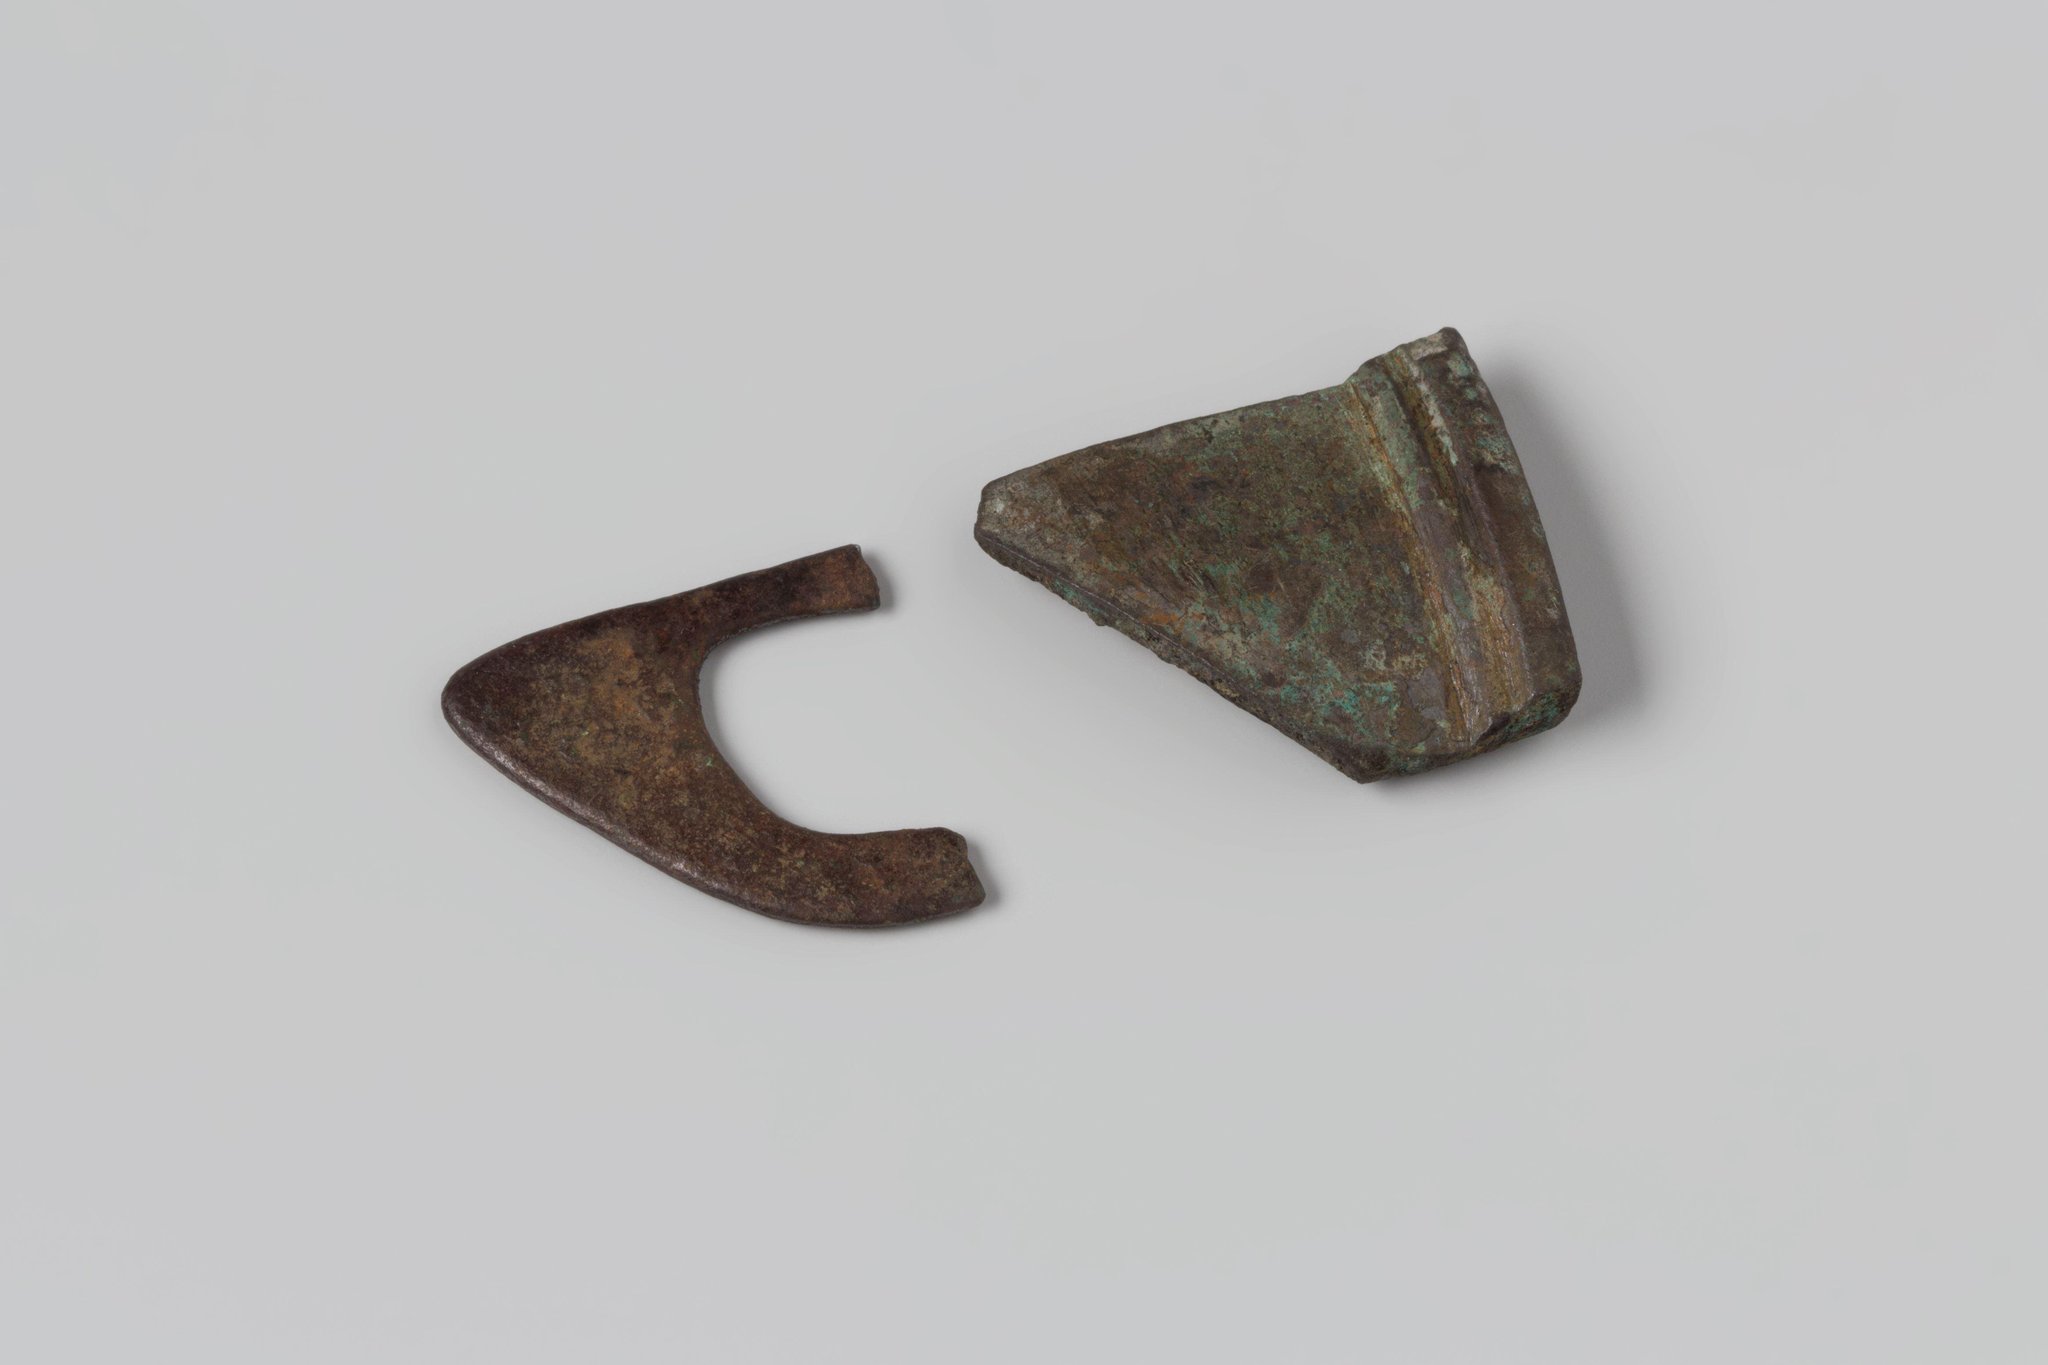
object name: scheepswrakvondst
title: Fragmenten van koper uit het wrak van de Oost-Indiëvaarder Hollandia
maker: Anonymous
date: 1700-1743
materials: copper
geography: netherlands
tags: verenigde oostindische compagnie, hollandia (schip), annet